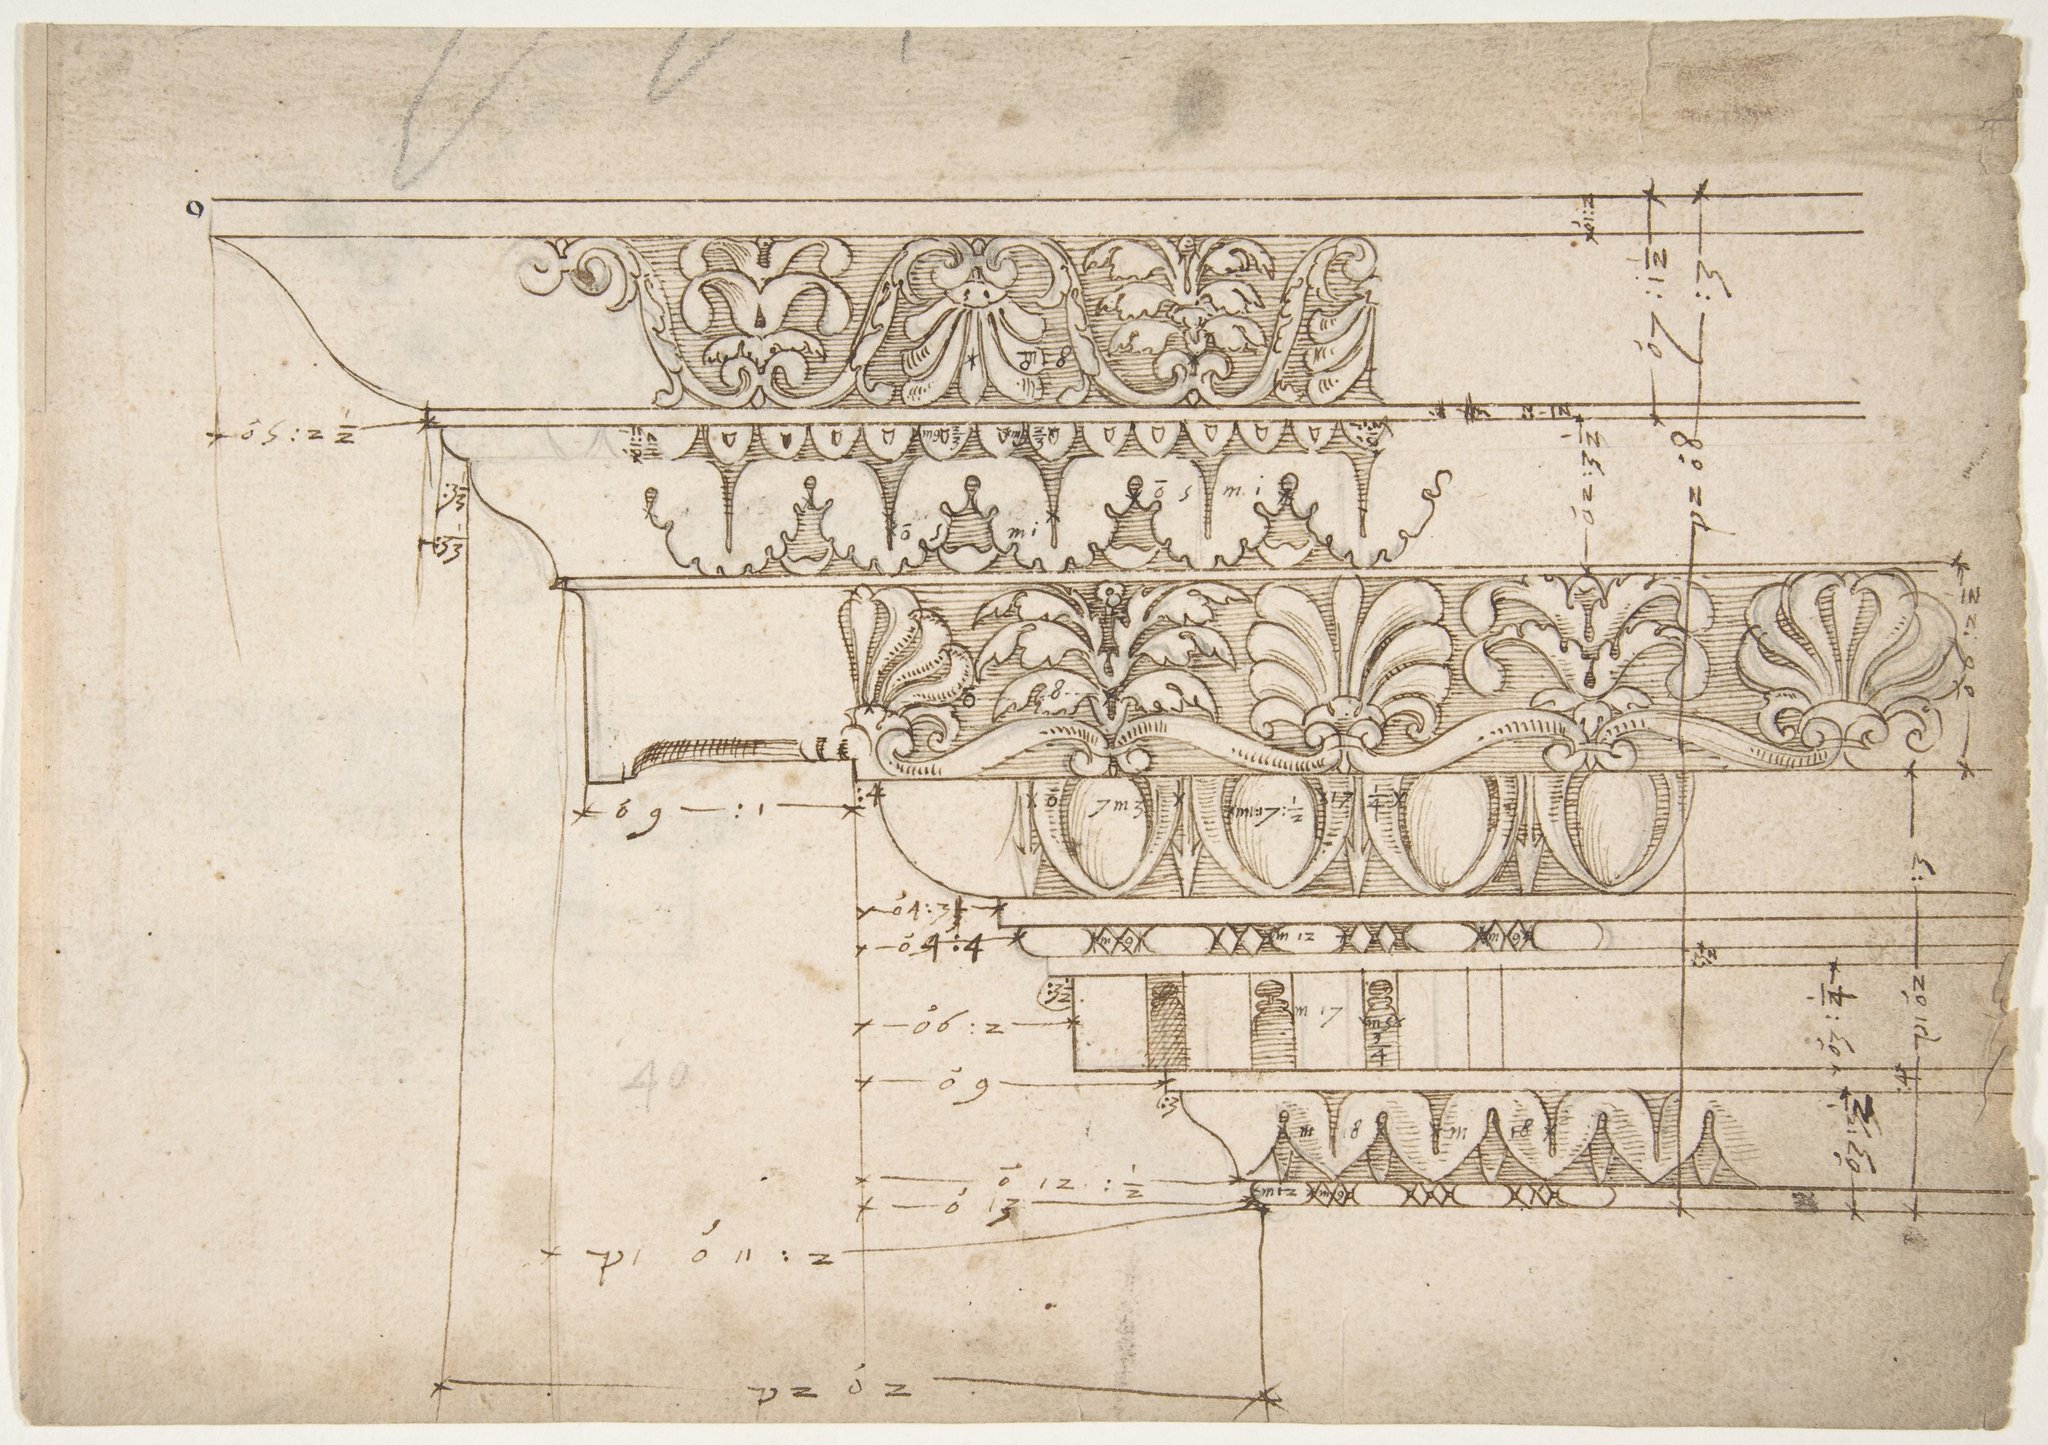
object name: collection ornament architecture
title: Domus Augustiana, cornice, elevation in profile, ornamental detailing (recto) Unidentified, cornice, elevation in profile, ornamental detailing (verso)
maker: anonymous, french, 16th century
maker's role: draftsman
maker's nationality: french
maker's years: 1500-1600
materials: chalk, ink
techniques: incising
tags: ornament